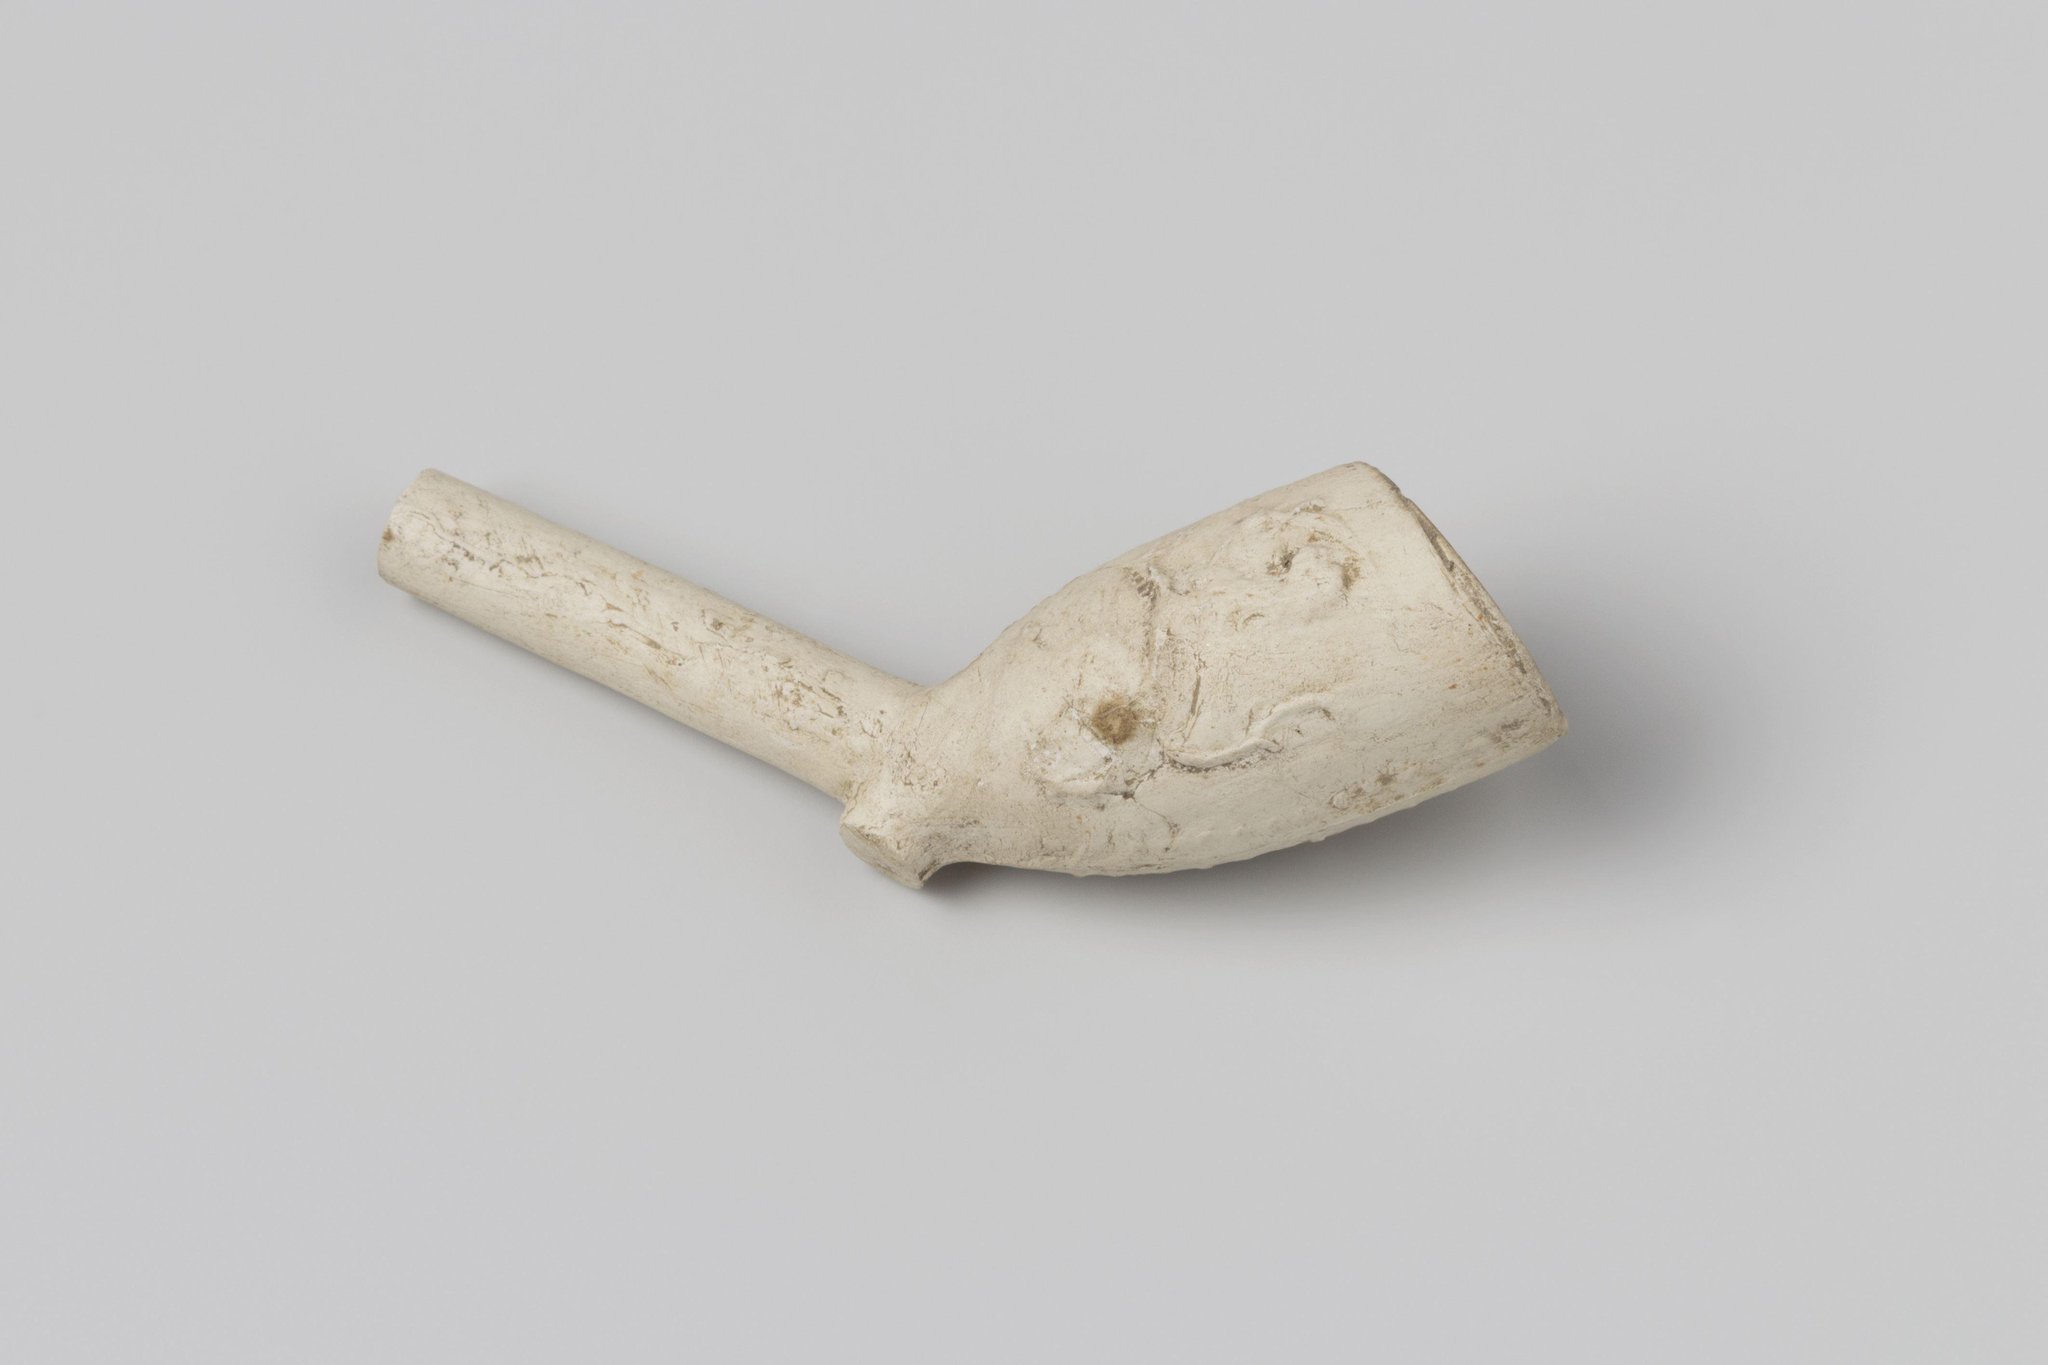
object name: pipe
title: Fragment van een tabakspijp.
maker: Anonymous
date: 1400-1950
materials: earthenware, clay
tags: loevestein castle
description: Fragment van een tabakspijp versierd met een ruiter en de Hollandse leeuw.